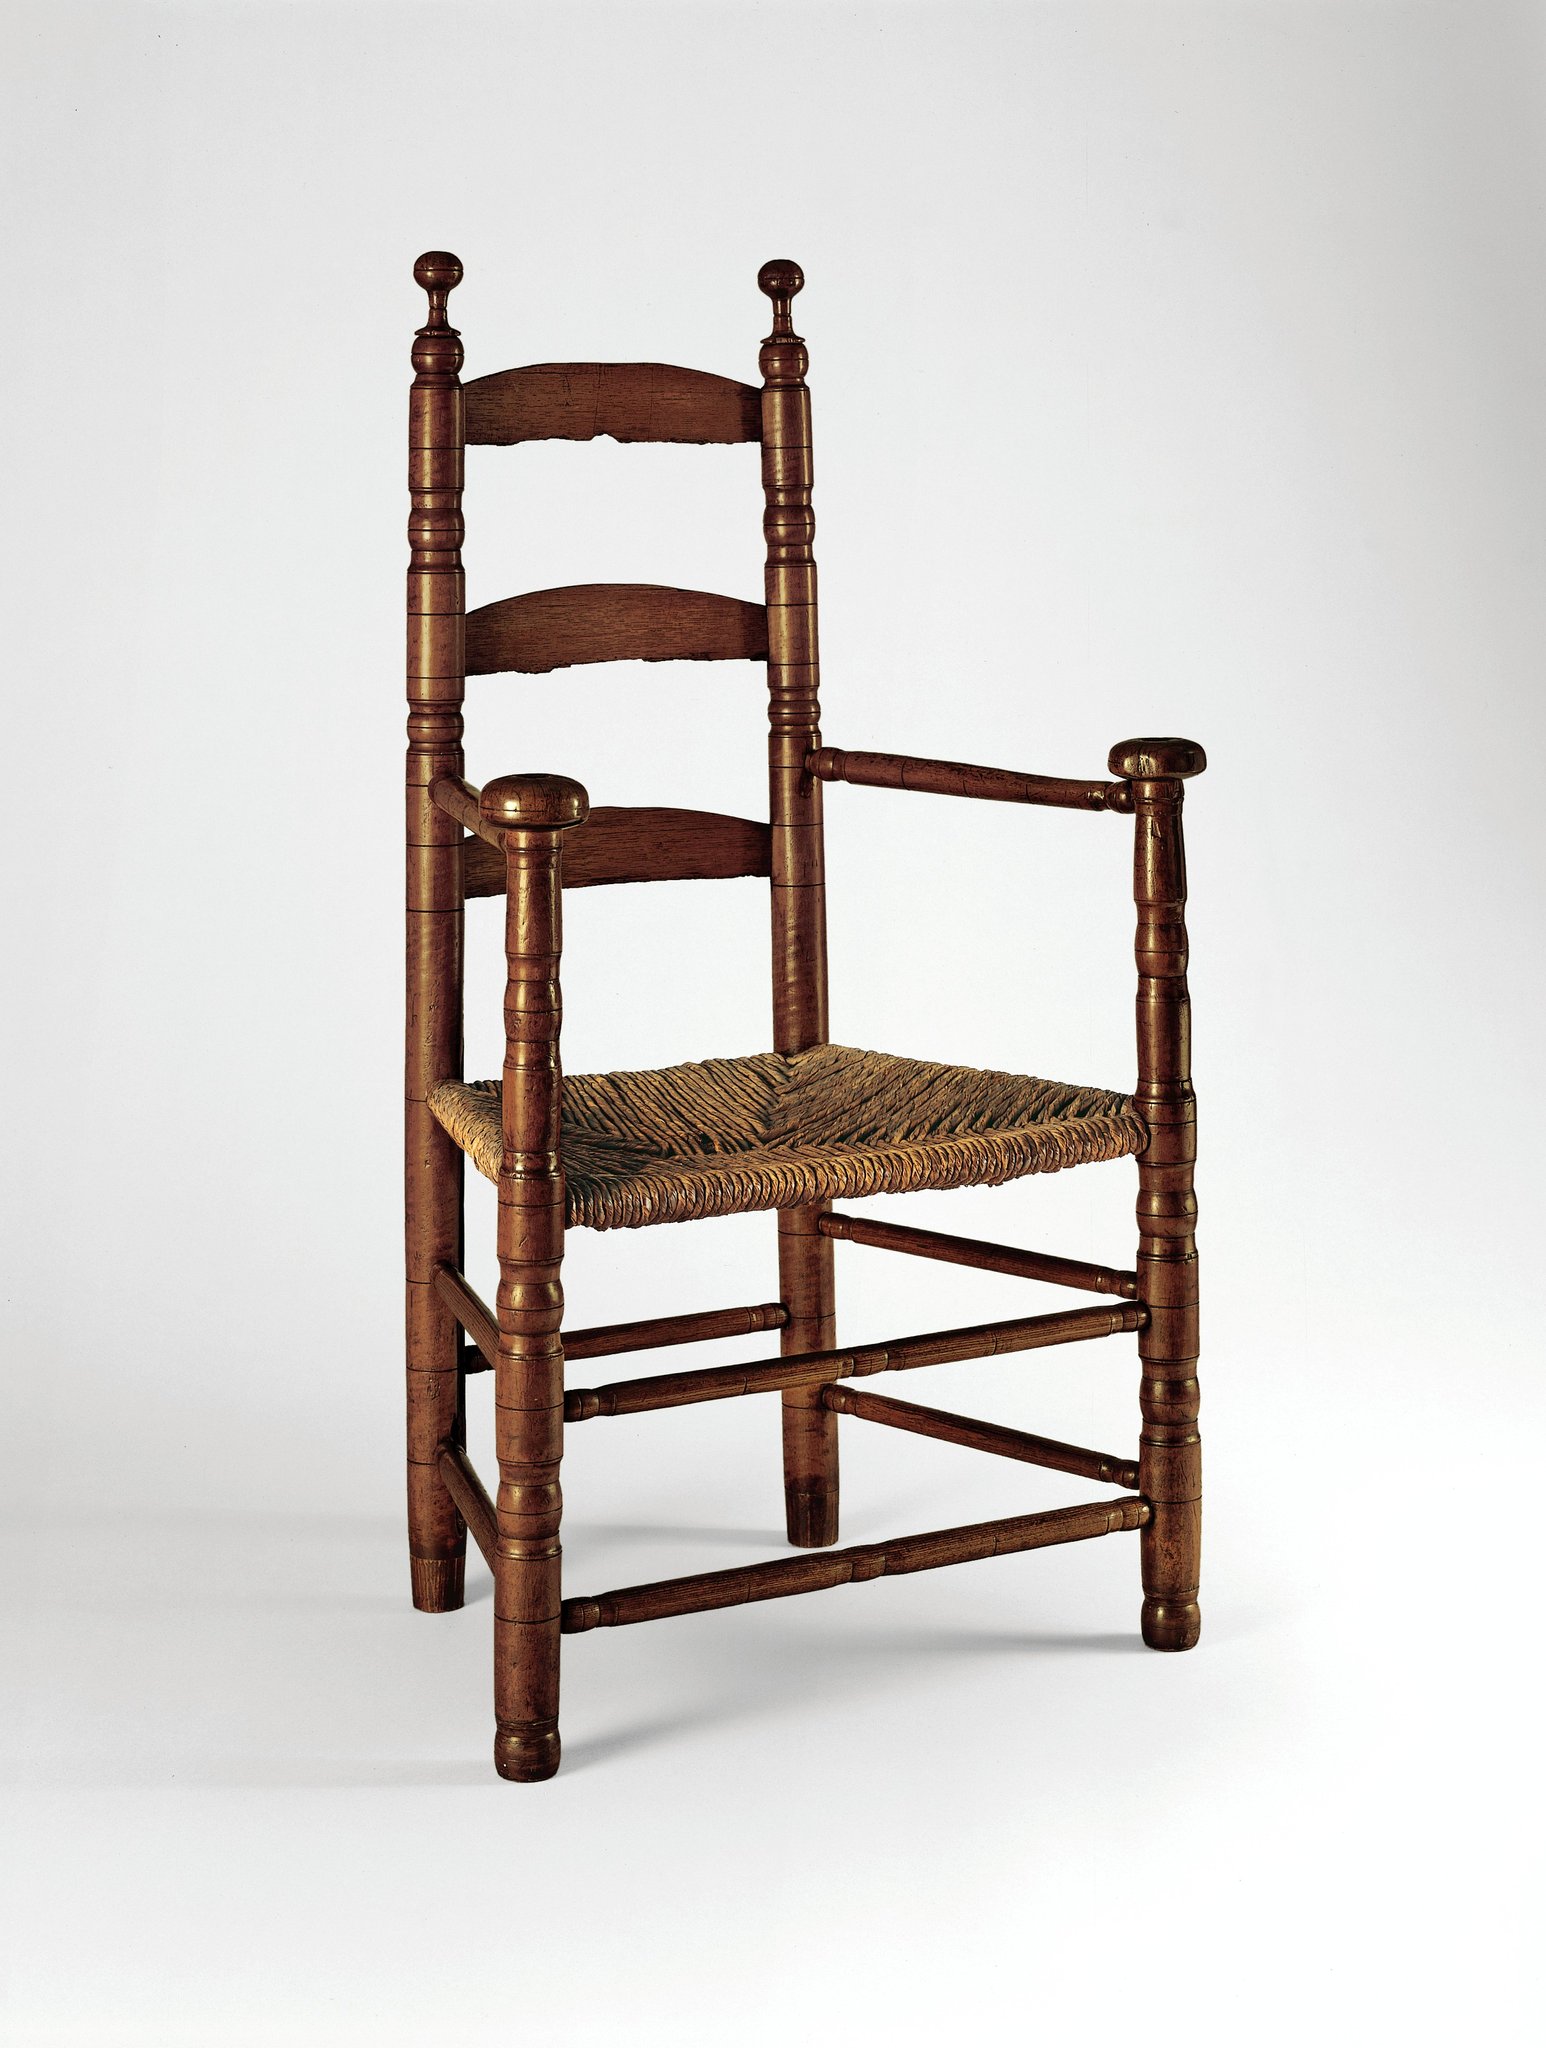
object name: armchair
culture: american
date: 1670-1700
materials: wood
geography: united states